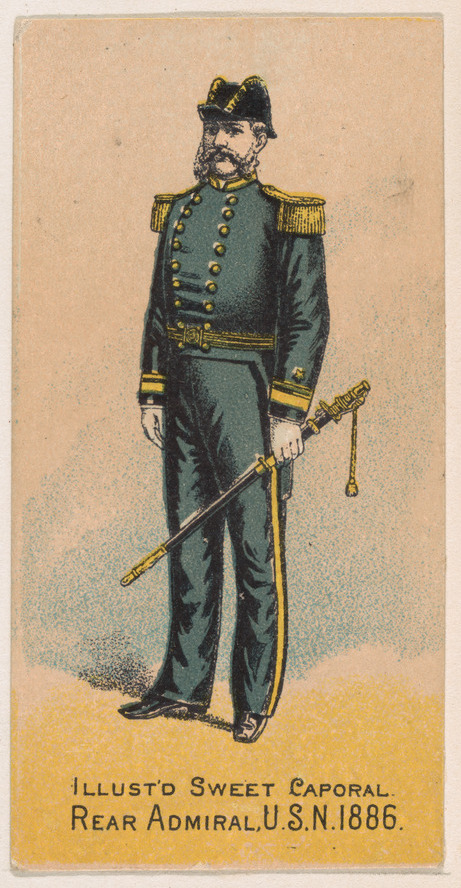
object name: print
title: Rear Admiral, United States Navy, 1886, from the Military Series (N224) issued by Kinney Tobacco Company to promote Sweet Caporal Cigarettes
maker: kinney brothers tobacco company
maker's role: publisher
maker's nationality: american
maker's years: 1869-2011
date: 1888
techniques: color lithograph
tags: navy,men,admirals